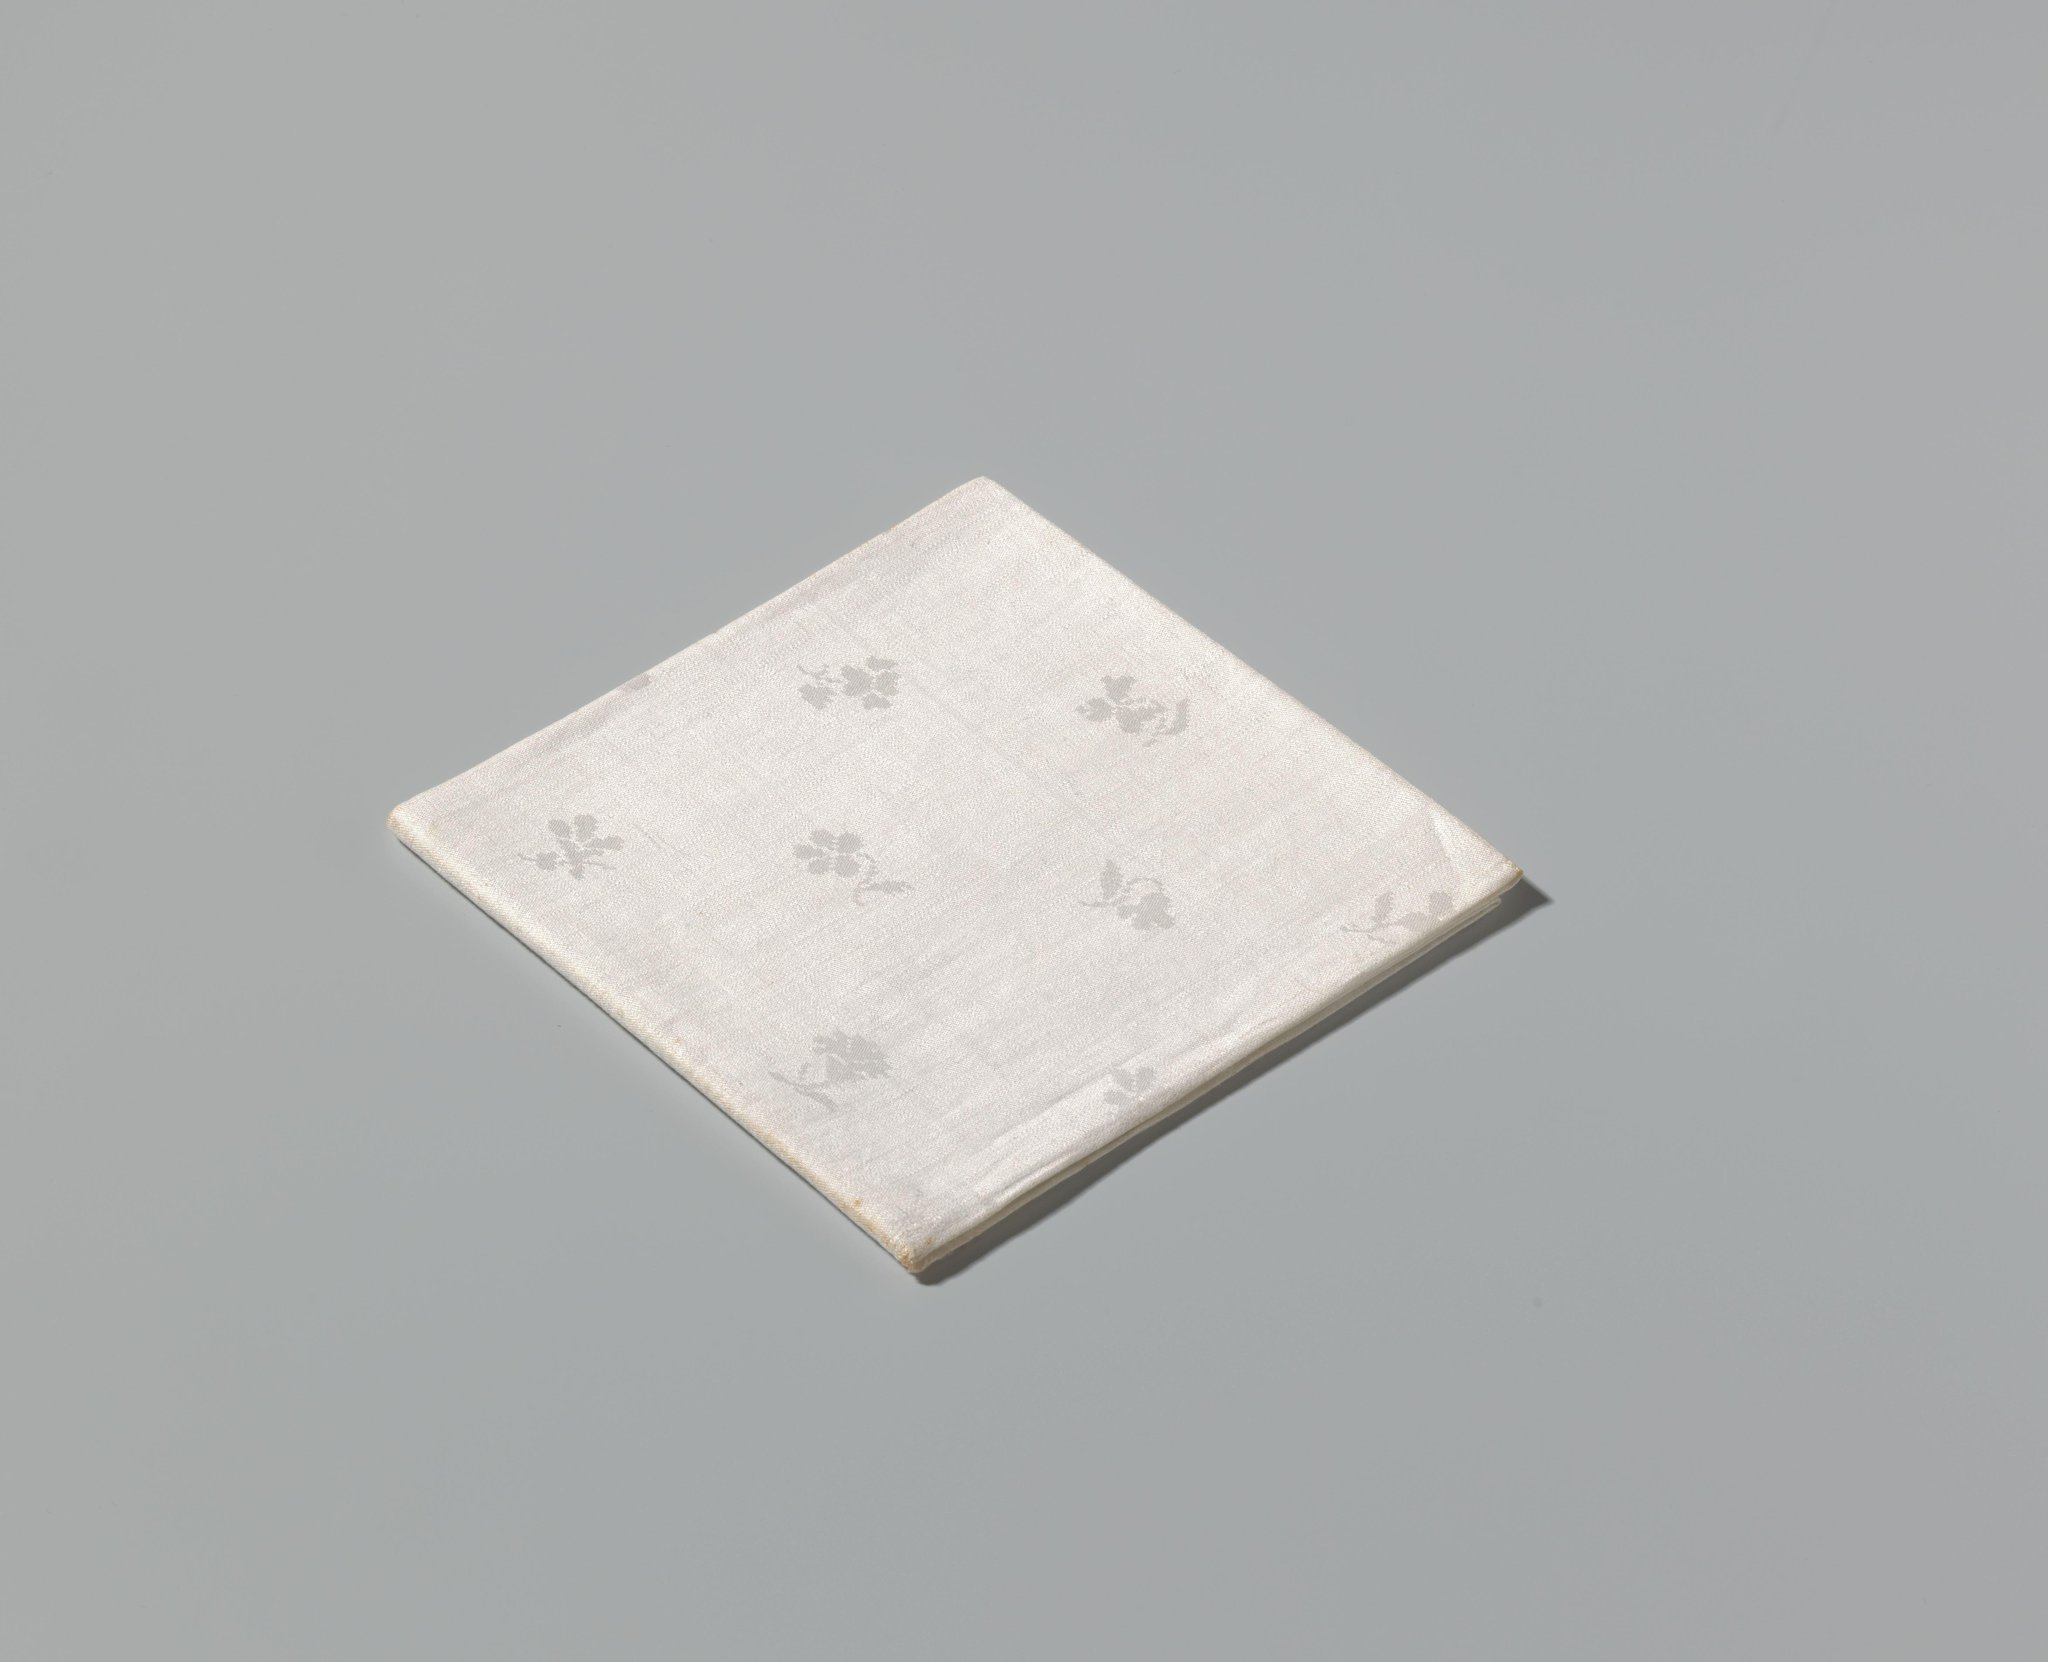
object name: napkin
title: Servet van wit linnendamast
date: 1820-1830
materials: linen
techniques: damask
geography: netherlands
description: Wit linnendamast servet met een patroon van gestrooide bloempjes en randen rondom, merk CW 12.